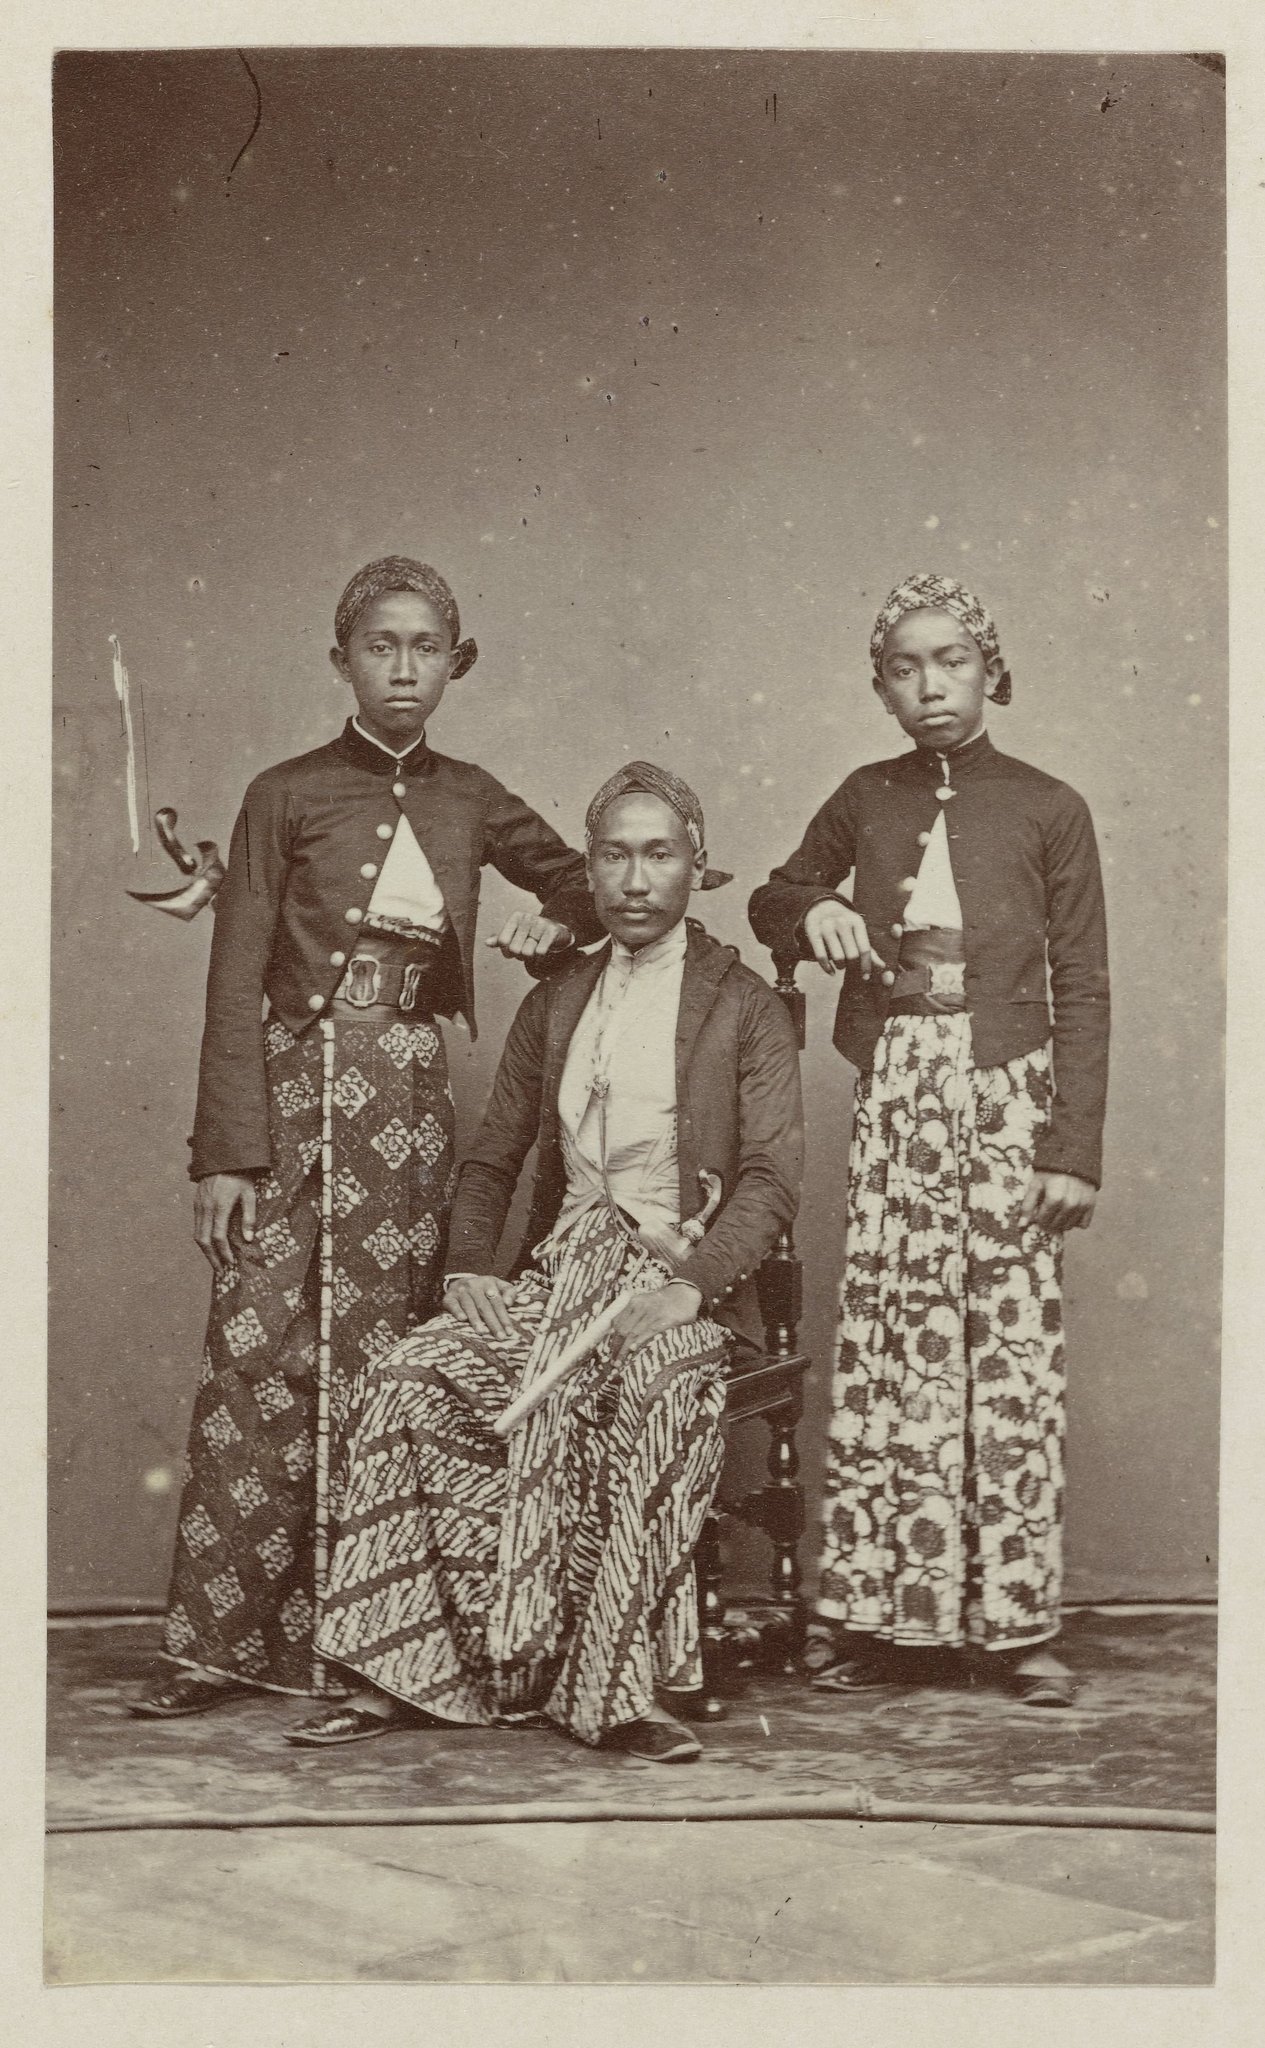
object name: photograph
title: Drie mannen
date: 1860-1890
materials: photographic support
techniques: albumen print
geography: batavia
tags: anonymous historical persons portrayed in a group, in a group-portrait, java, batavia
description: Studioportret van drie mannen, waarschijnlijk een regent met zijn twee zonen, waarschijnlijk te Batavia. Ingeplakte foto in het fotoalbum getiteld: Gezichten van Java.